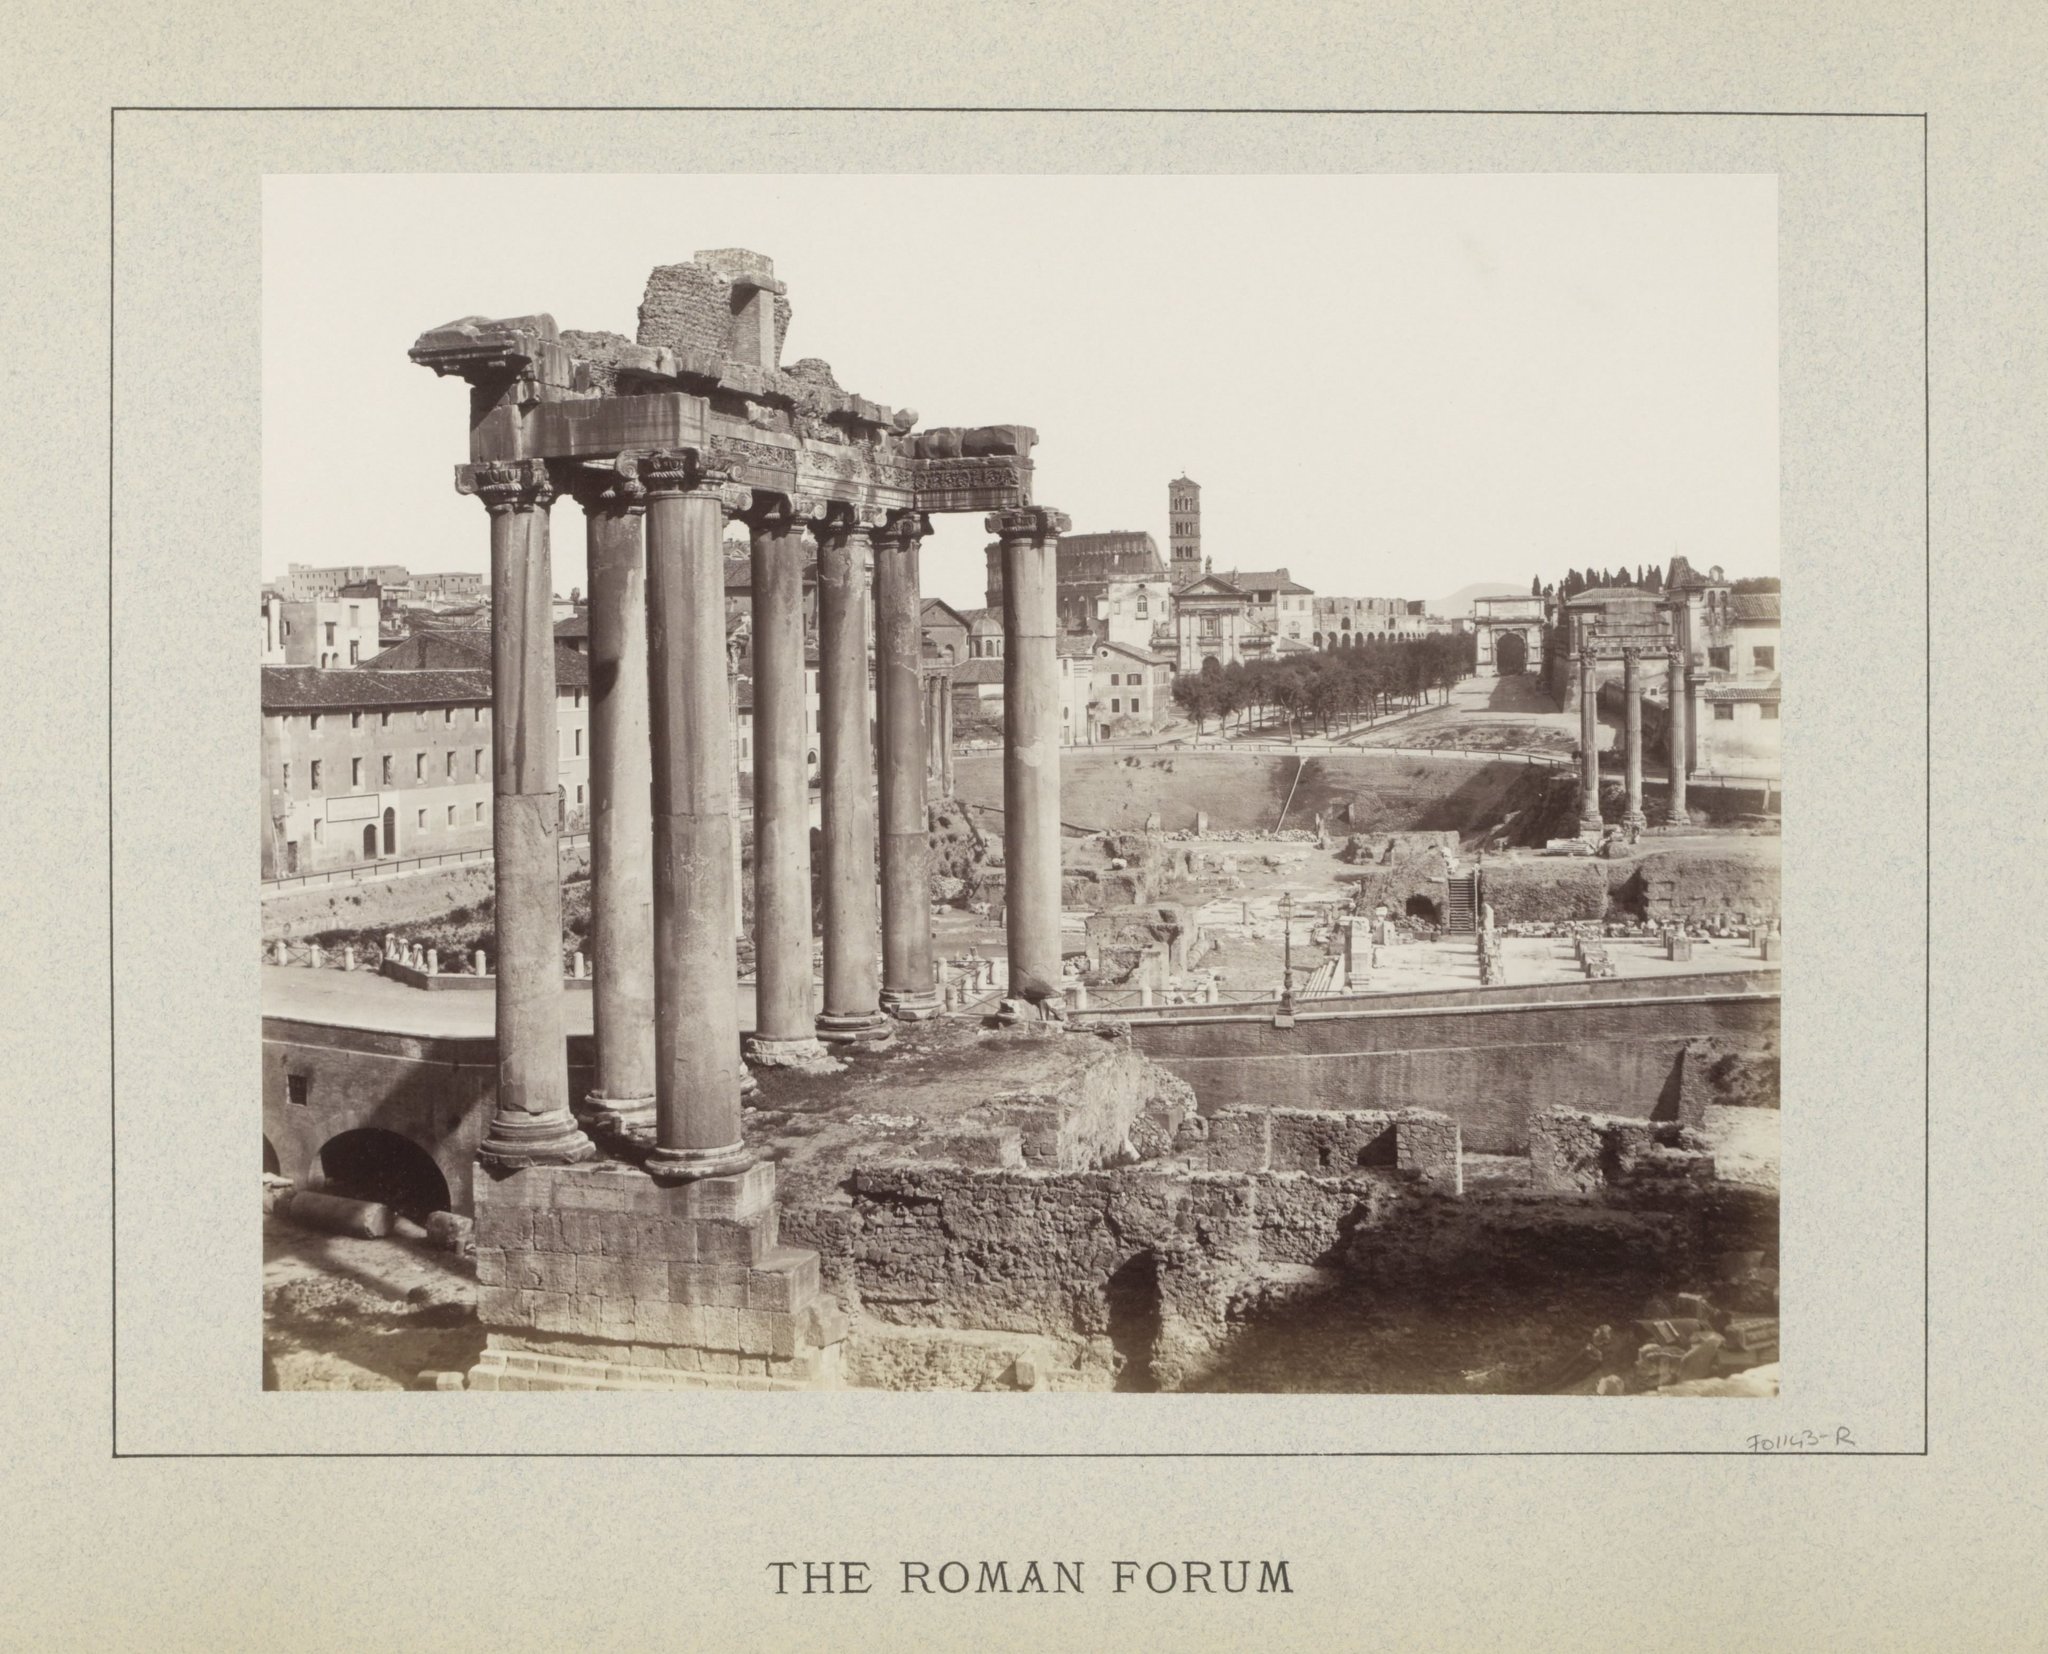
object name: photograph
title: Gezicht op het Forum Romanum in Rome met links de zuilen van de Tempel van Saturnus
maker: Anonymous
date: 1860-1900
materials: photographic support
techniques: albumen print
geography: forum romanum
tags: ruin of a building ~ architecture, square, place, circus, etc. (+ city(-scape) with figures, staffage), prospect of city, town panorama, silhouette of city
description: Onderdeel van Fotoalbum met opnames van bezienswaardigheden en kunstwerken in Rome.